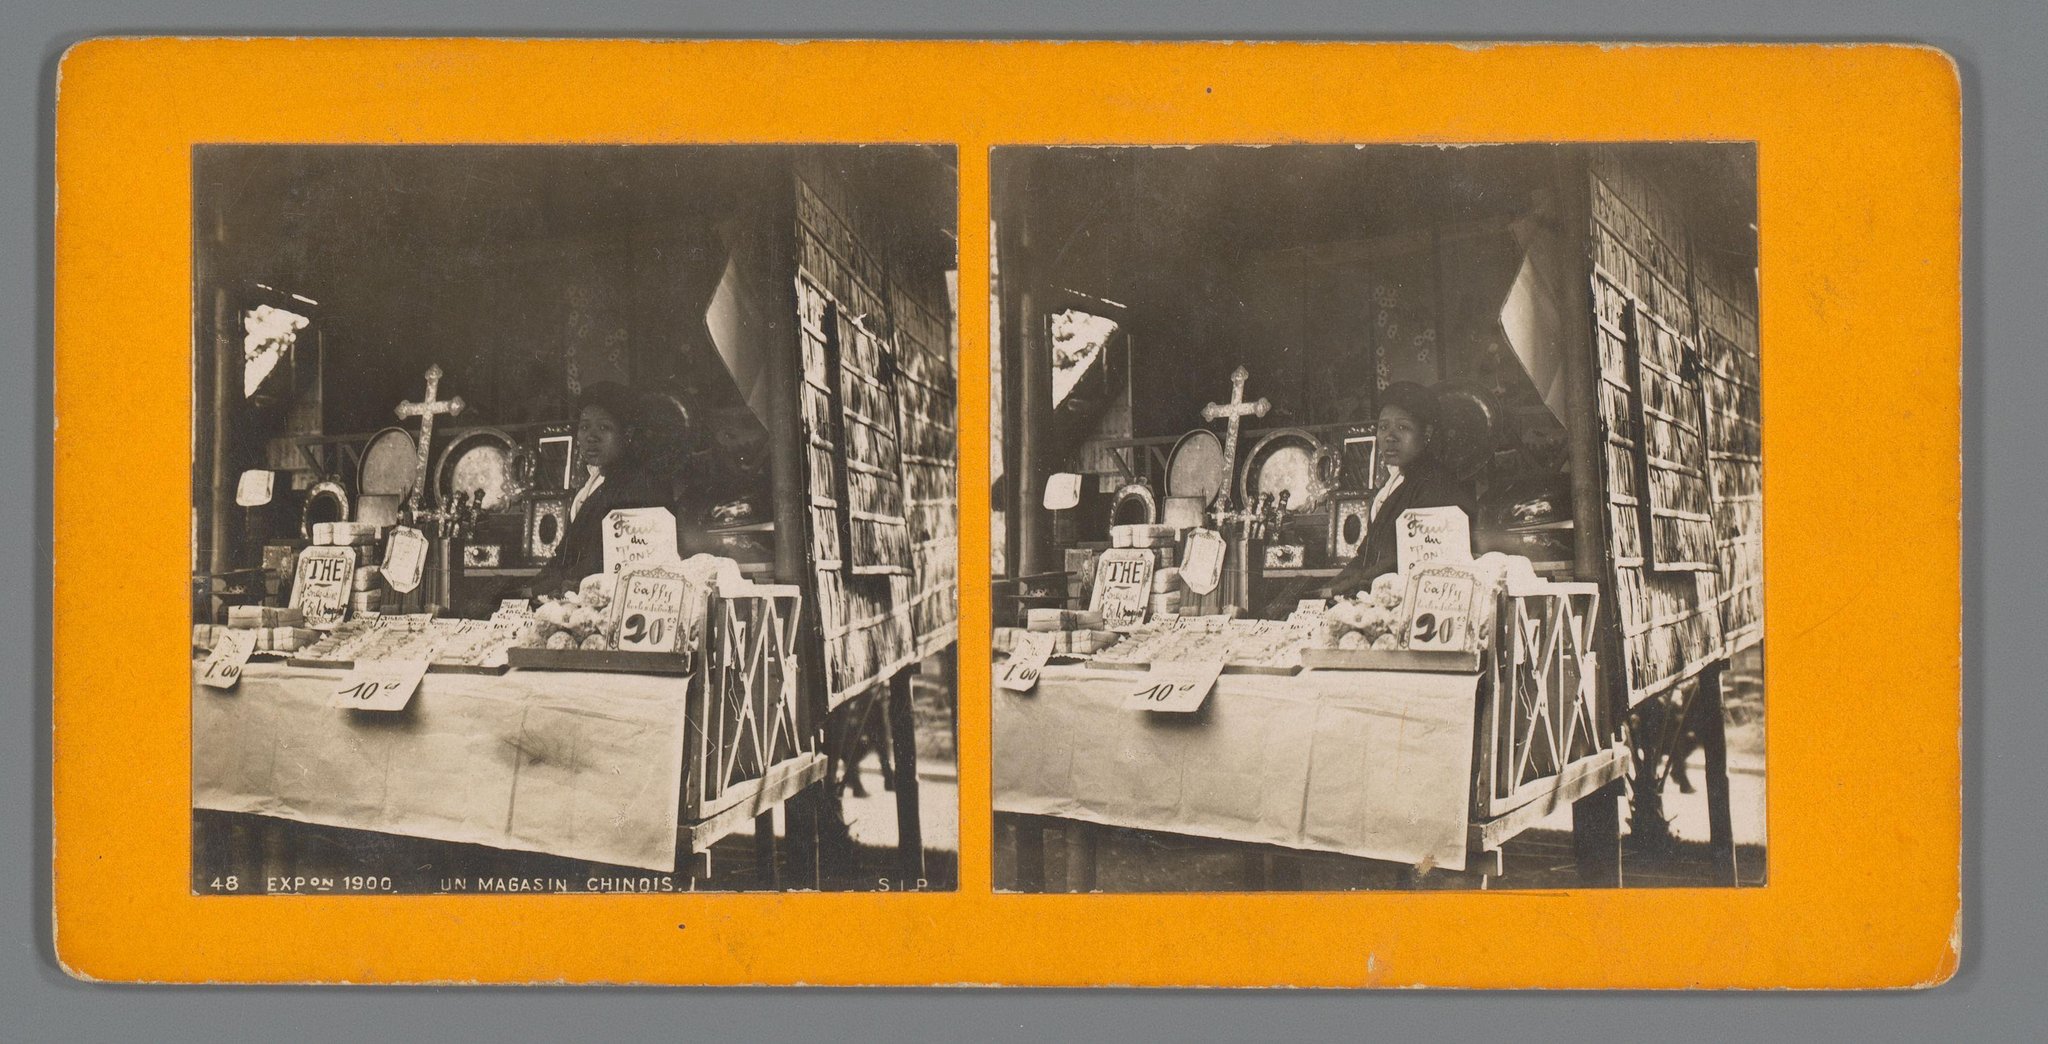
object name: stereograph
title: Kraam met Chinese waren tijdens de Wereldtentoonstelling van 1900 in Parijs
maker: Anonymous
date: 1900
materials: paper, cardboard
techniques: gelatin silver print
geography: paris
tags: stall, booth (~ market), paris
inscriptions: number: ‘48’